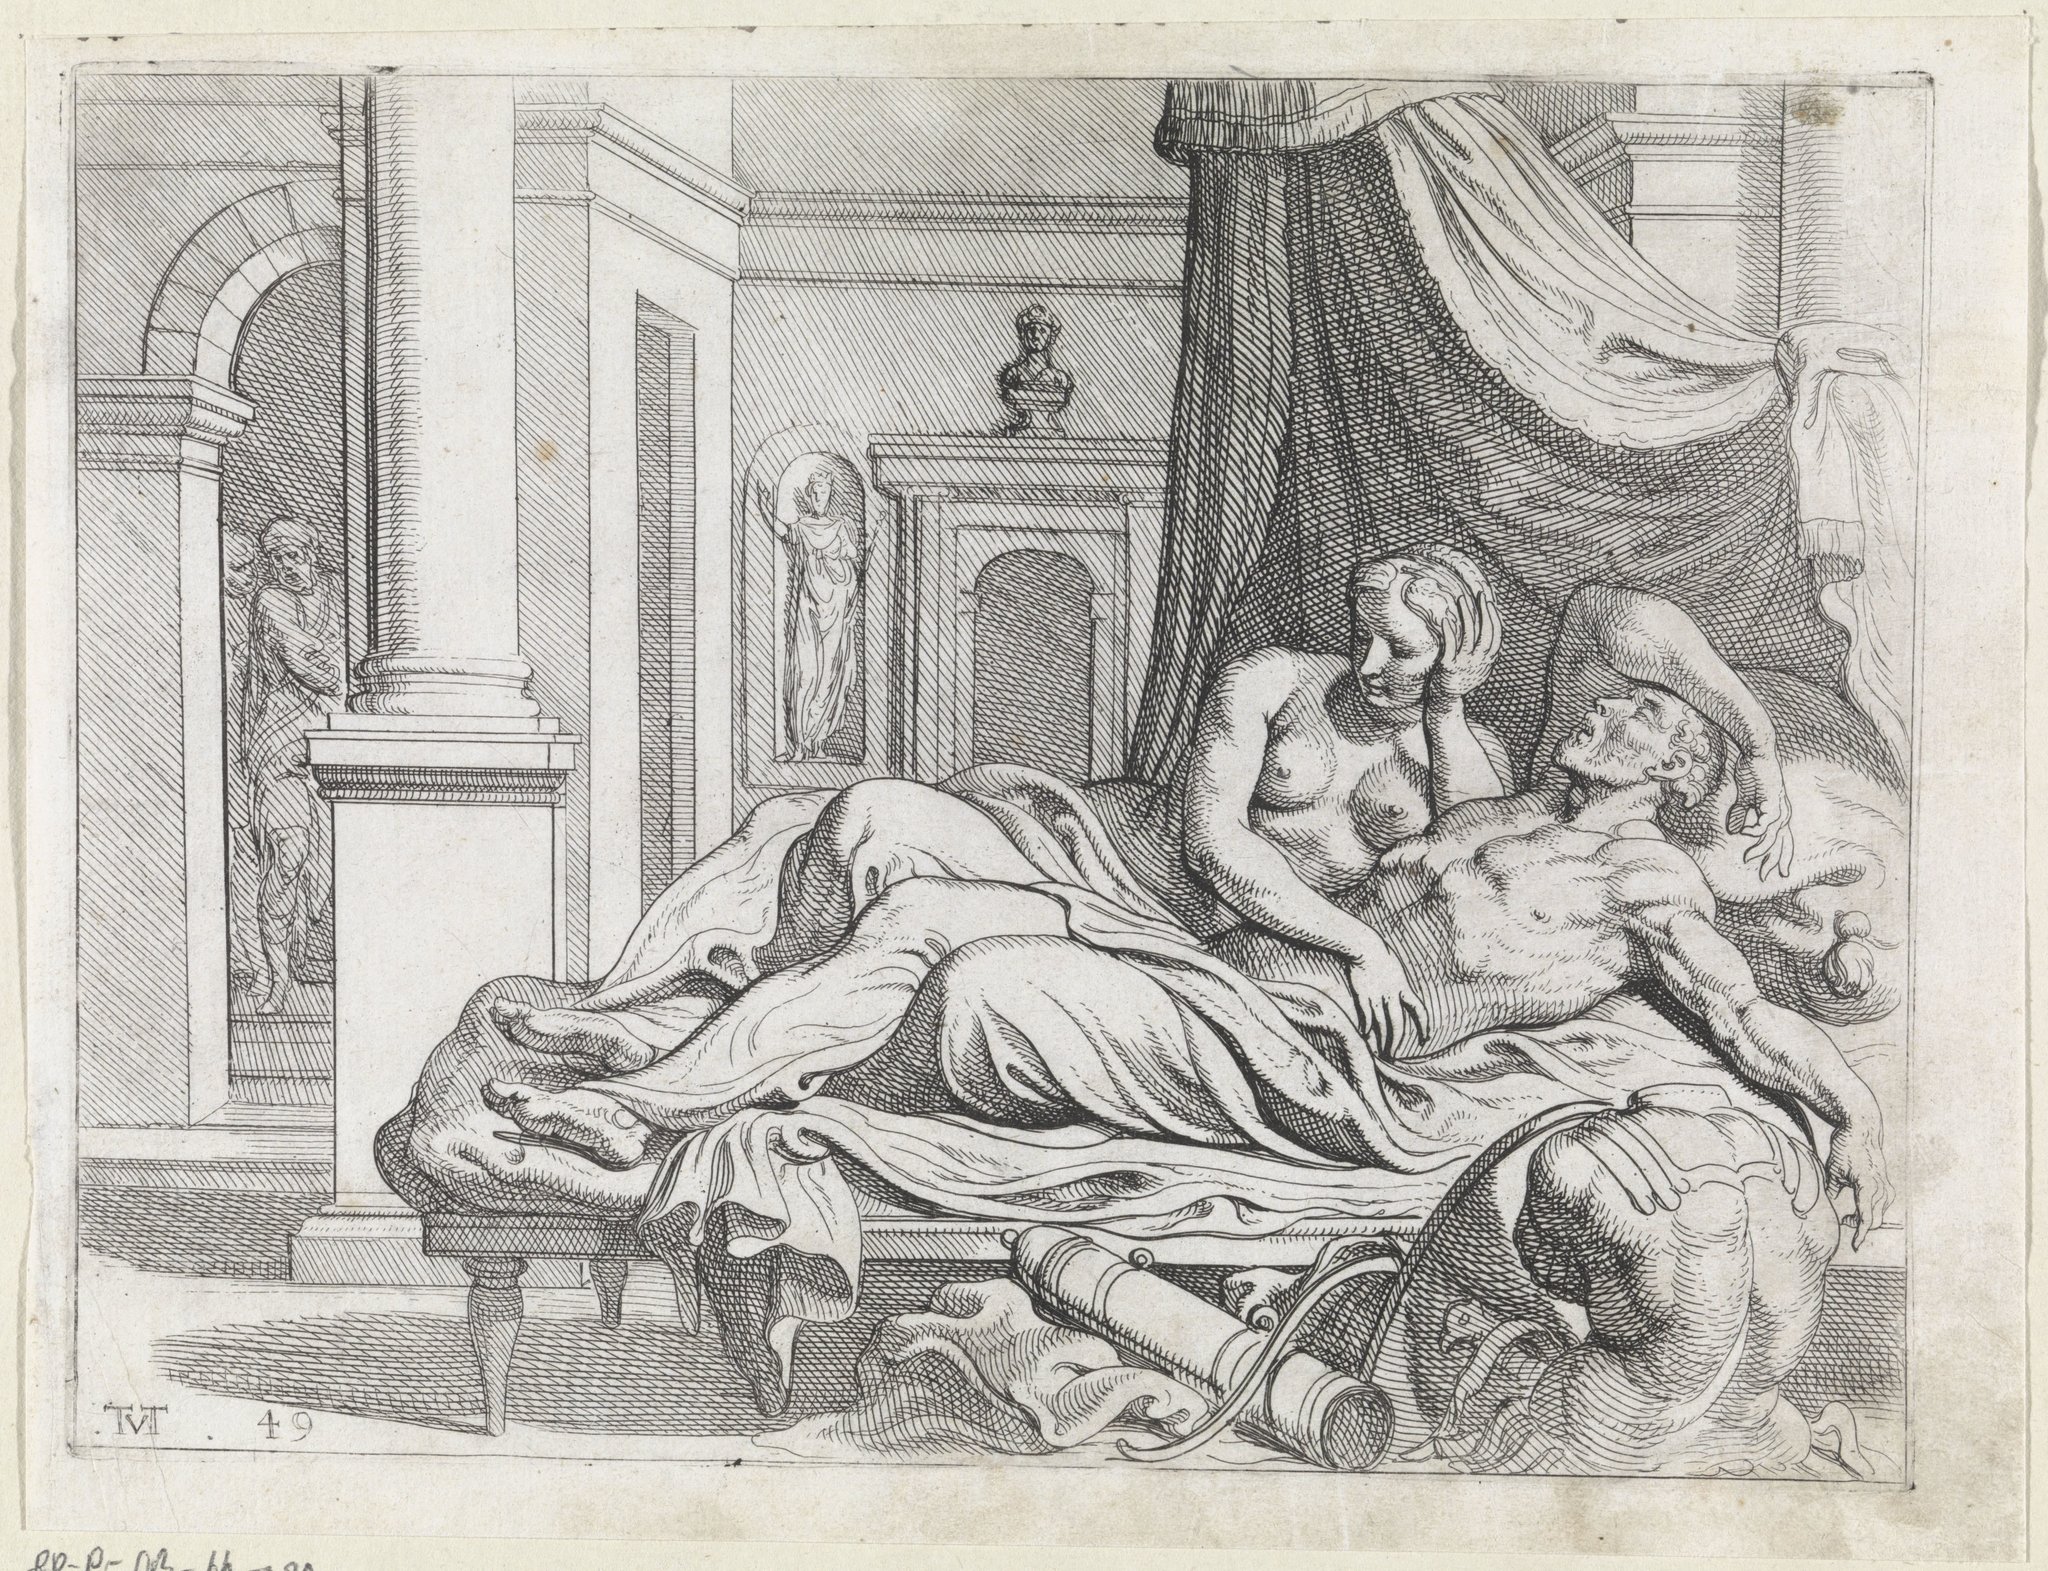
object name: print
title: De werken van Odysseus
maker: theodoor van thulden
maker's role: draughtsman, painter, print maker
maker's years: 1606-1669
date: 1632-1633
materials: paper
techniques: engraving, etching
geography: paris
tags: penelope and ulysses reunited (homer, odyssey xxiii)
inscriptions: collector's mark: Lugt 2228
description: Nadat Odysseus Penelope heeft verteld van zijn avonturen, is hij in slaap gevallen. Penelope is nog wakker en vraagt zich af of de man naast haar werkelijk Odysseus is.